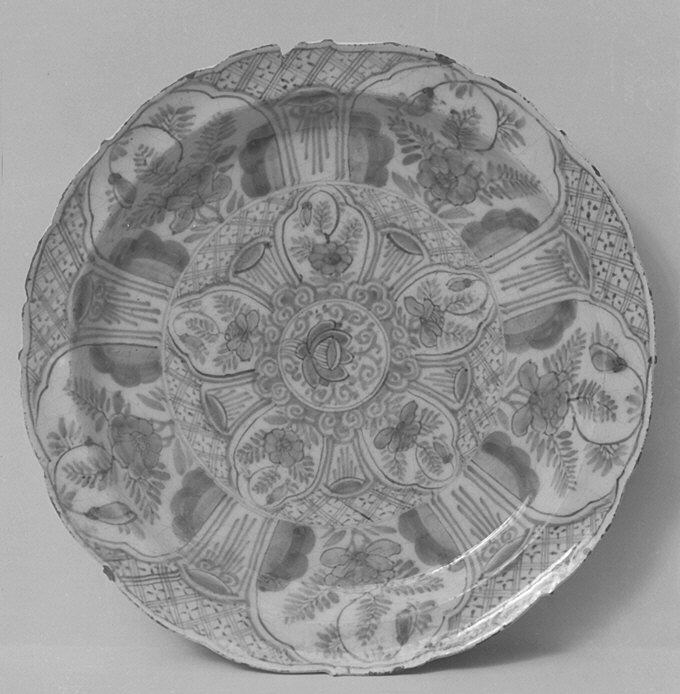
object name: plate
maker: de metaale pot factory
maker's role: factory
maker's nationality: dutch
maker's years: 1670-1775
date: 1700-1720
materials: earthenware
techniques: glazing